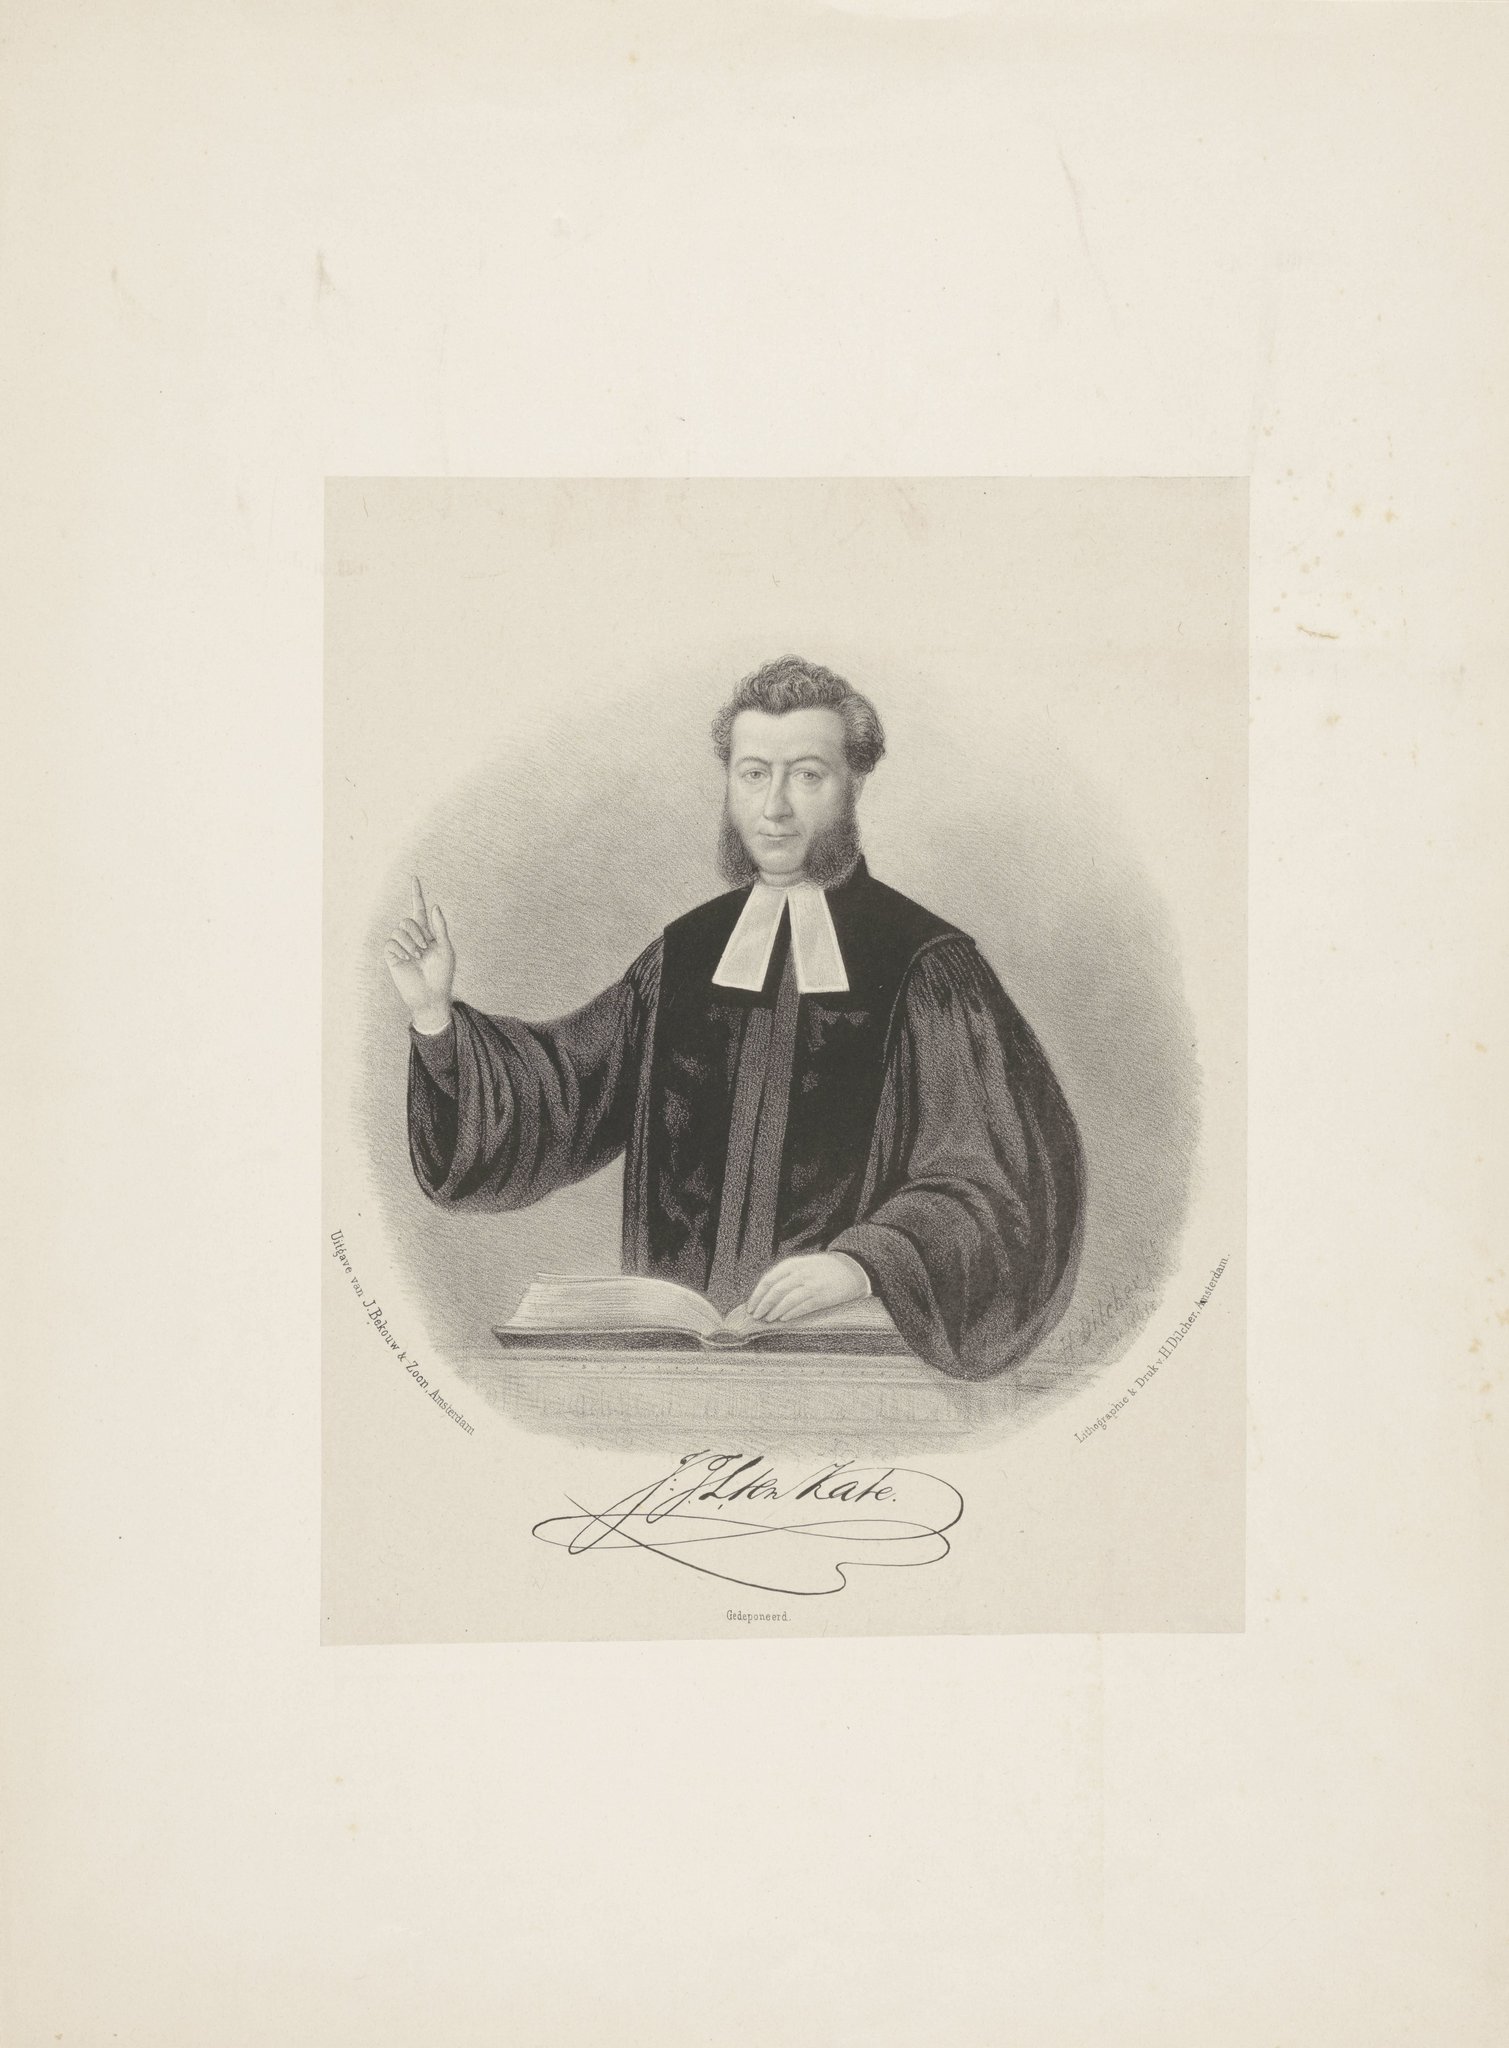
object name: print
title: Portret van Jan Jakob Lodewijk ten Kate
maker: heinrich dilcher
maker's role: print maker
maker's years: 1824-1885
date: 1856-1865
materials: paper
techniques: lithograph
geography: amsterdam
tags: the hague, jan jakob lodewijk ten kate, book - mm - book open, historical persons (+ half-length portrait), index finger upwards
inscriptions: collector's mark: Lugt 2228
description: De geportretteerde staat achter een tafel of spreekgestoelte. Voor hem ligt een open geslagen boek. Hij draagt een toga en bef. Met zijn recherhand maakt hij een spreekgebaar. Onder het portret zijn signatuur.